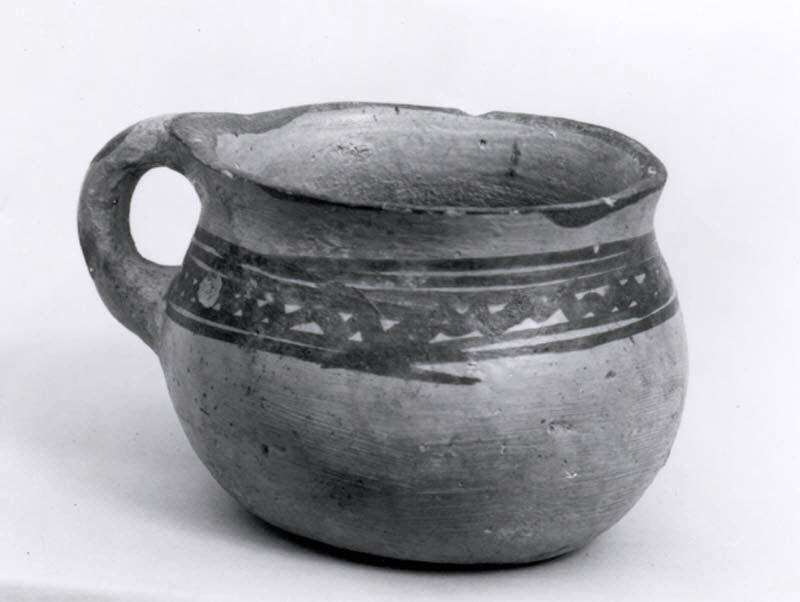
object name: cup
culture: iranian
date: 2000-1600 BCE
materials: ceramic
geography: iran, luristan